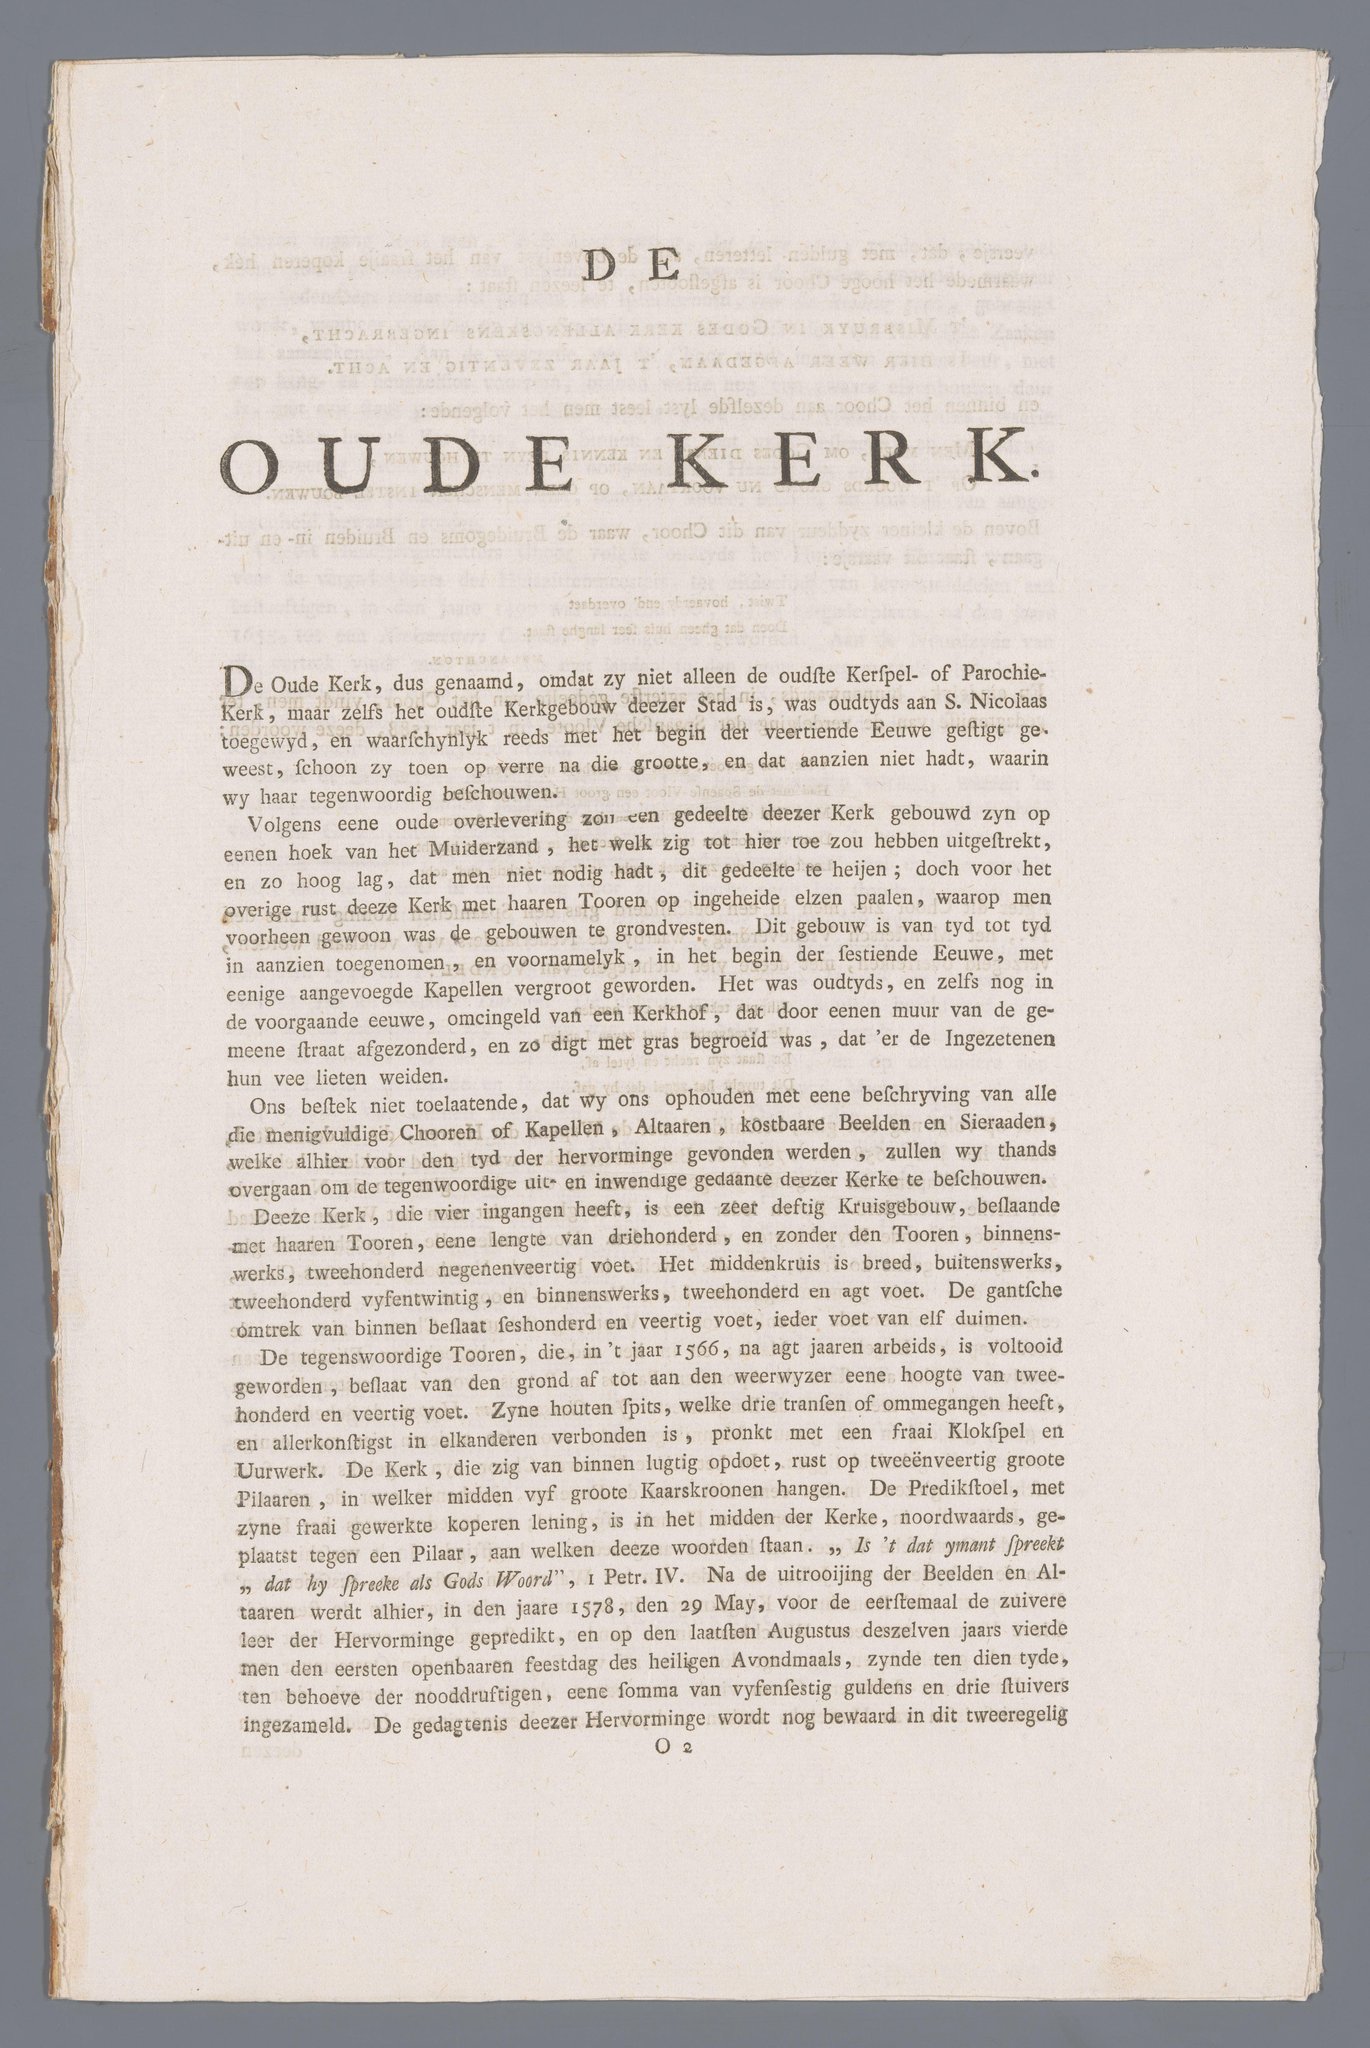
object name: text sheet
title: Beschrijving van de Oude Kerk te Amsterdam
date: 1783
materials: paper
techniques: letterpress printing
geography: amsterdam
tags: protestant churches and denominations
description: Tekstblad uit: Nieuwe atlas, van de voornaamste gebouwen en gezigten der stad Amsterdam, met derzelver beknopte beschryvingen. 2 dln. Amsterdam: Daniël Jean Changuion en Petrus den Hengst [in opdracht van Pierre Fouquet], 1783, dl. 2.